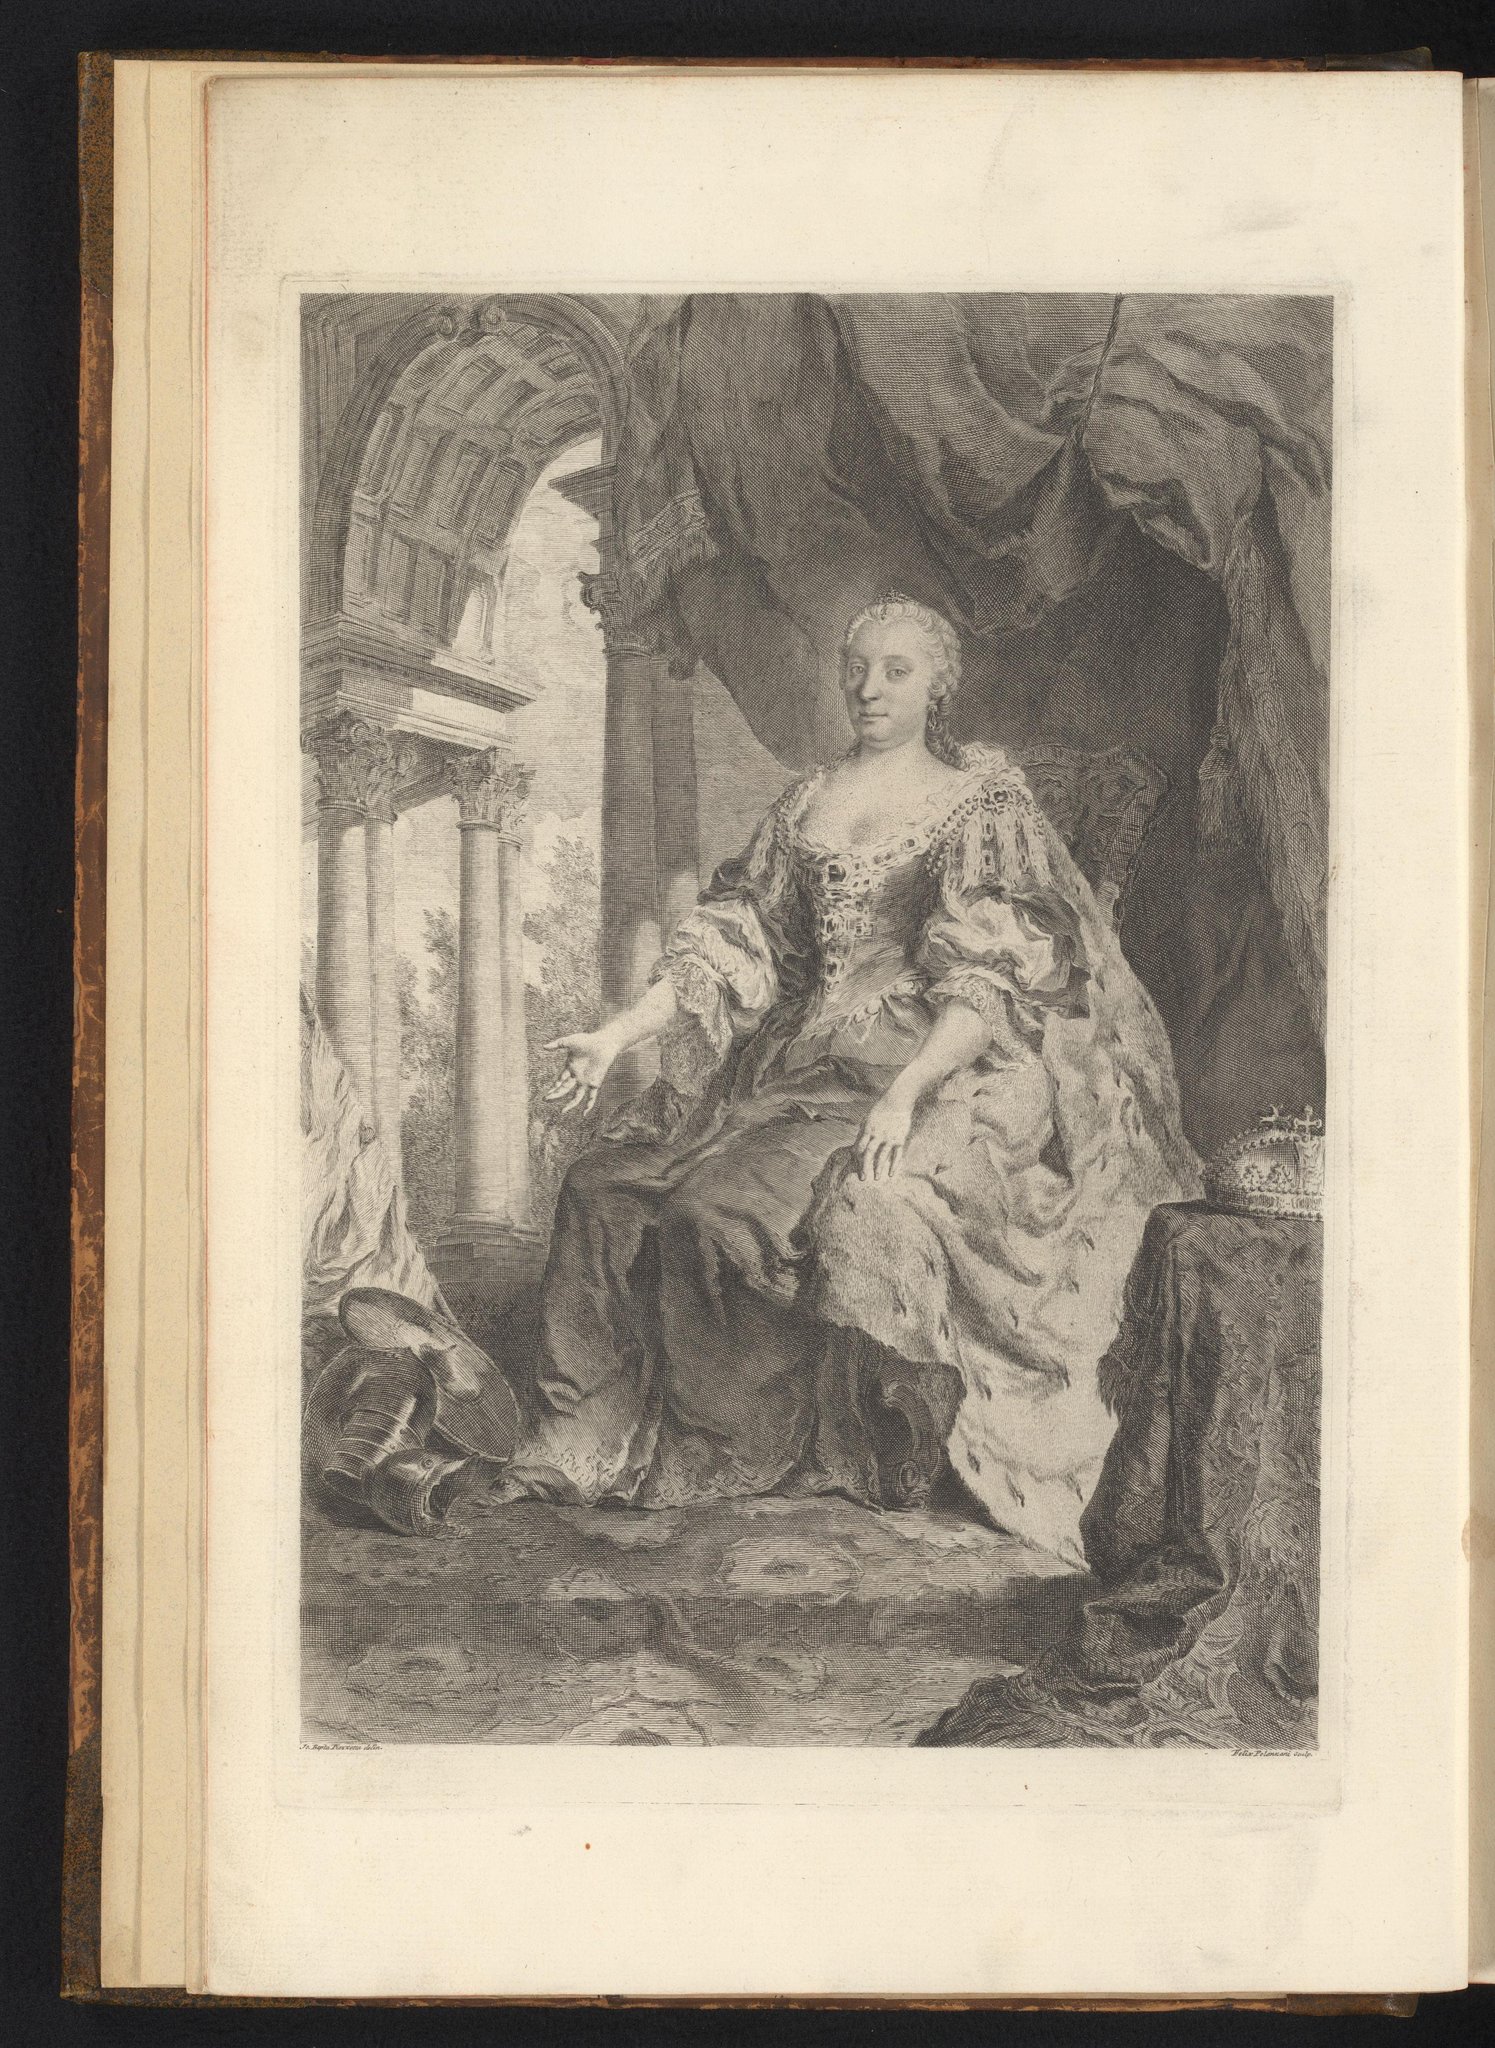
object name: print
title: Portret van Maria Theresia van Oostenrijk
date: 1745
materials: paper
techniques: engraving, etching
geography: venice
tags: vienna, maria theresia (rooms-duits keizerin), historical persons - bb - woman, emperor - bb - female ruler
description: Prent uit: Tasso, Torquato. La Gerusalemme liberata di Torquato Tasso con le figure de Giambatista Piazzetta. Venetië: Giambatista Albrizzi, 1745.